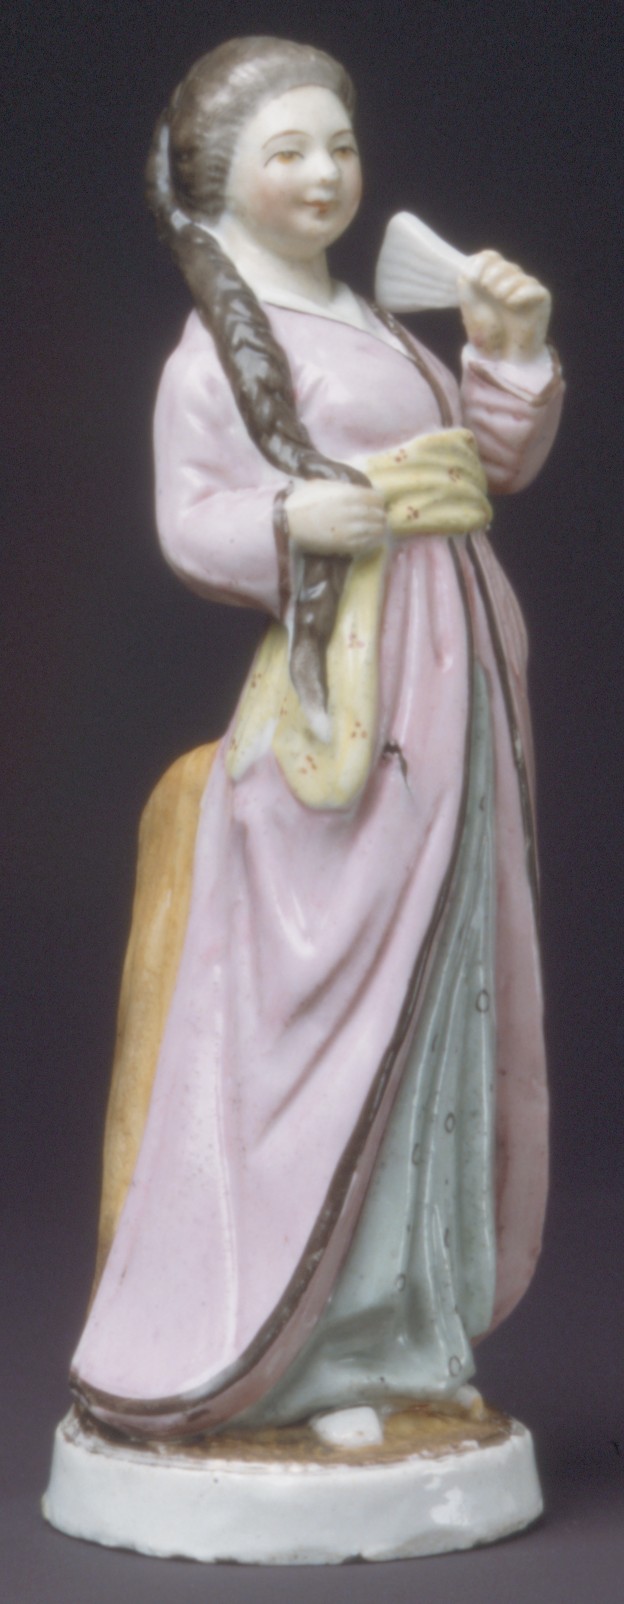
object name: figure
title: Oriental Woman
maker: imperial porcelain manufactory, st. petersburg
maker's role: manufactory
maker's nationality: russian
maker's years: 1744-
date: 1800-1850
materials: hard paste porcelain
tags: fans,women